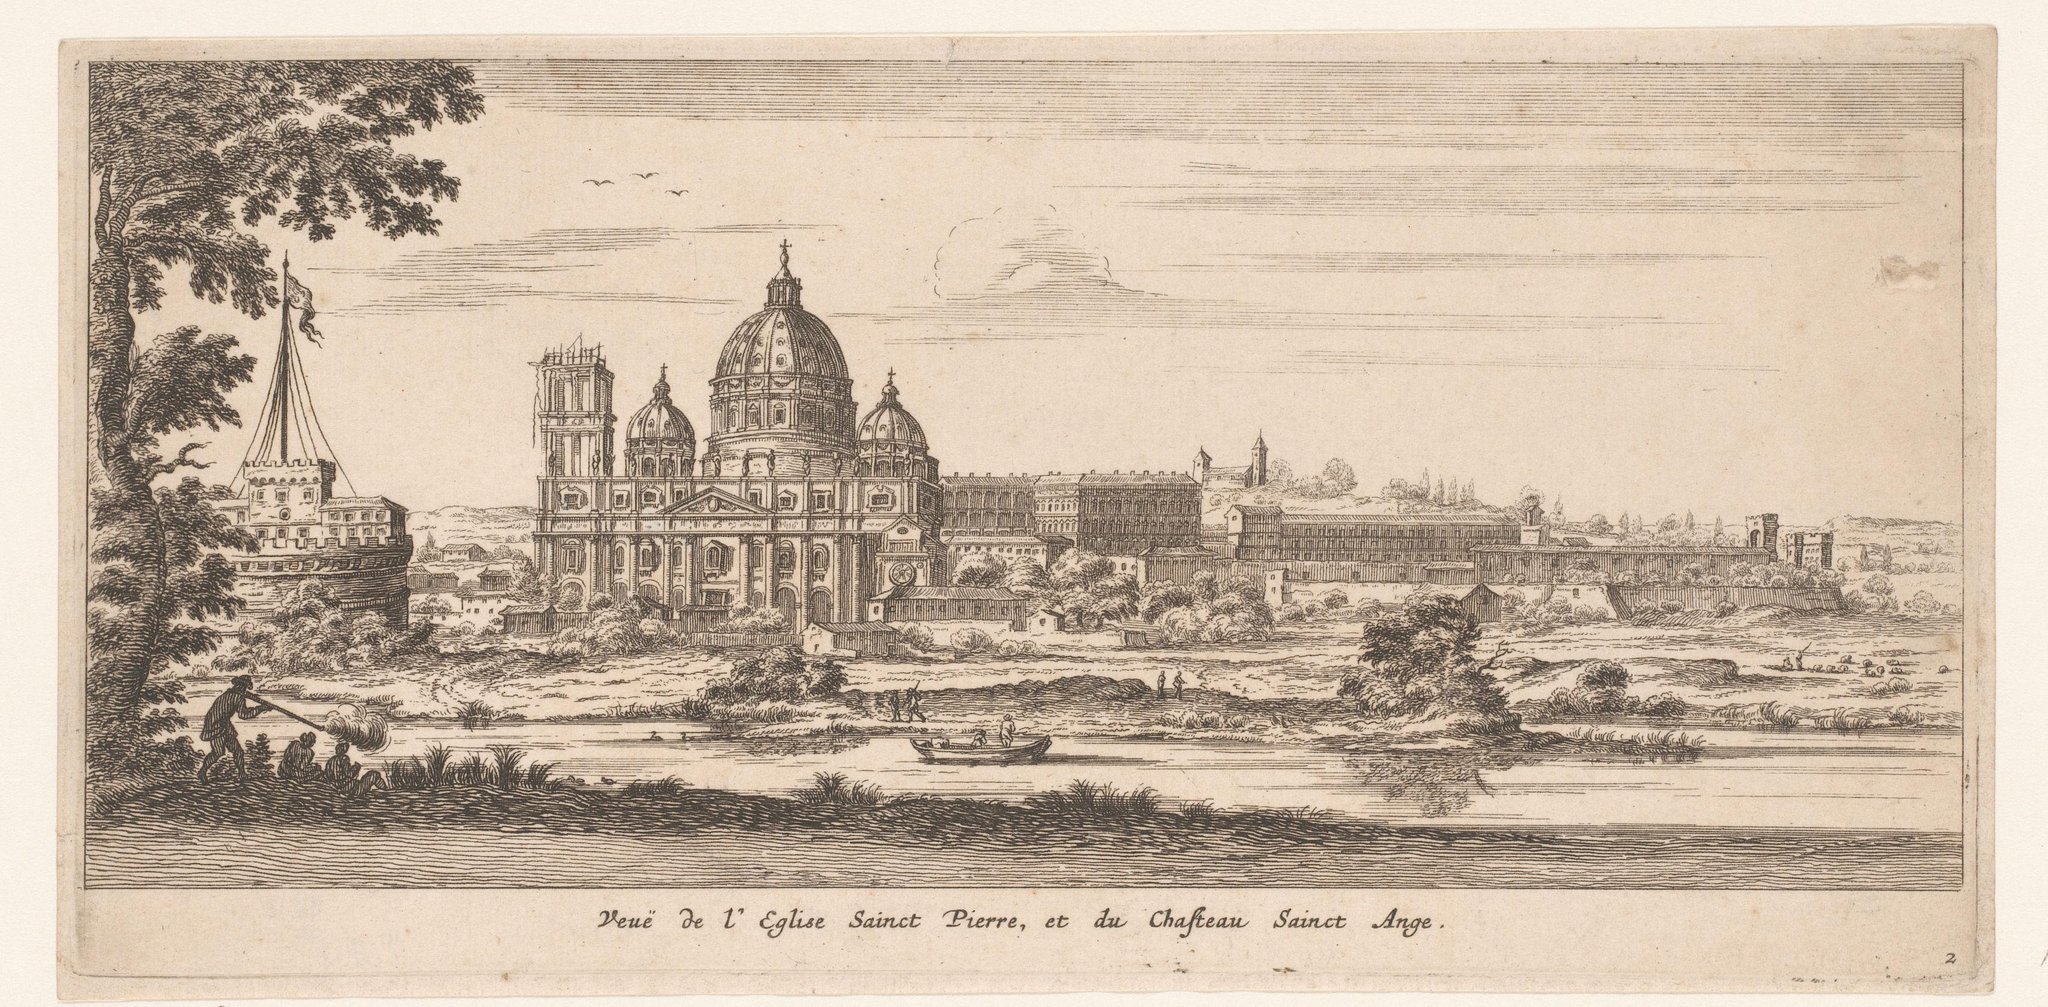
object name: print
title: Diverses veuës de Rome et des environs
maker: françois collignon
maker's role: print maker, publisher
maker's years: 1610-1687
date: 1631-1687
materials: paper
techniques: engraving, etching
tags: city-view in general; 'veduta'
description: Prent maakt deel uit van een serie van tien prenten, deels ongenummerd.